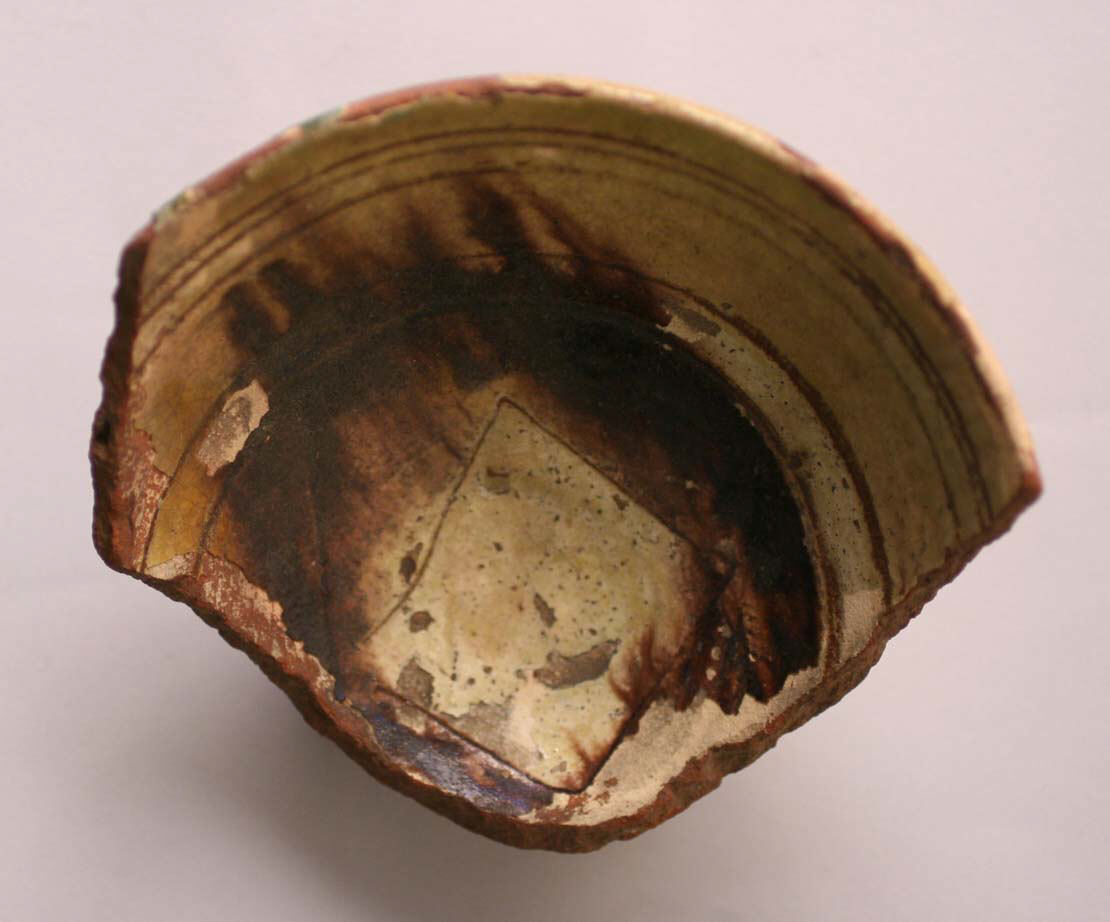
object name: fragment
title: Fragment of a Bowl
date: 1301-1500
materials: earthenware, glaze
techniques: coloring, incising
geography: egypt